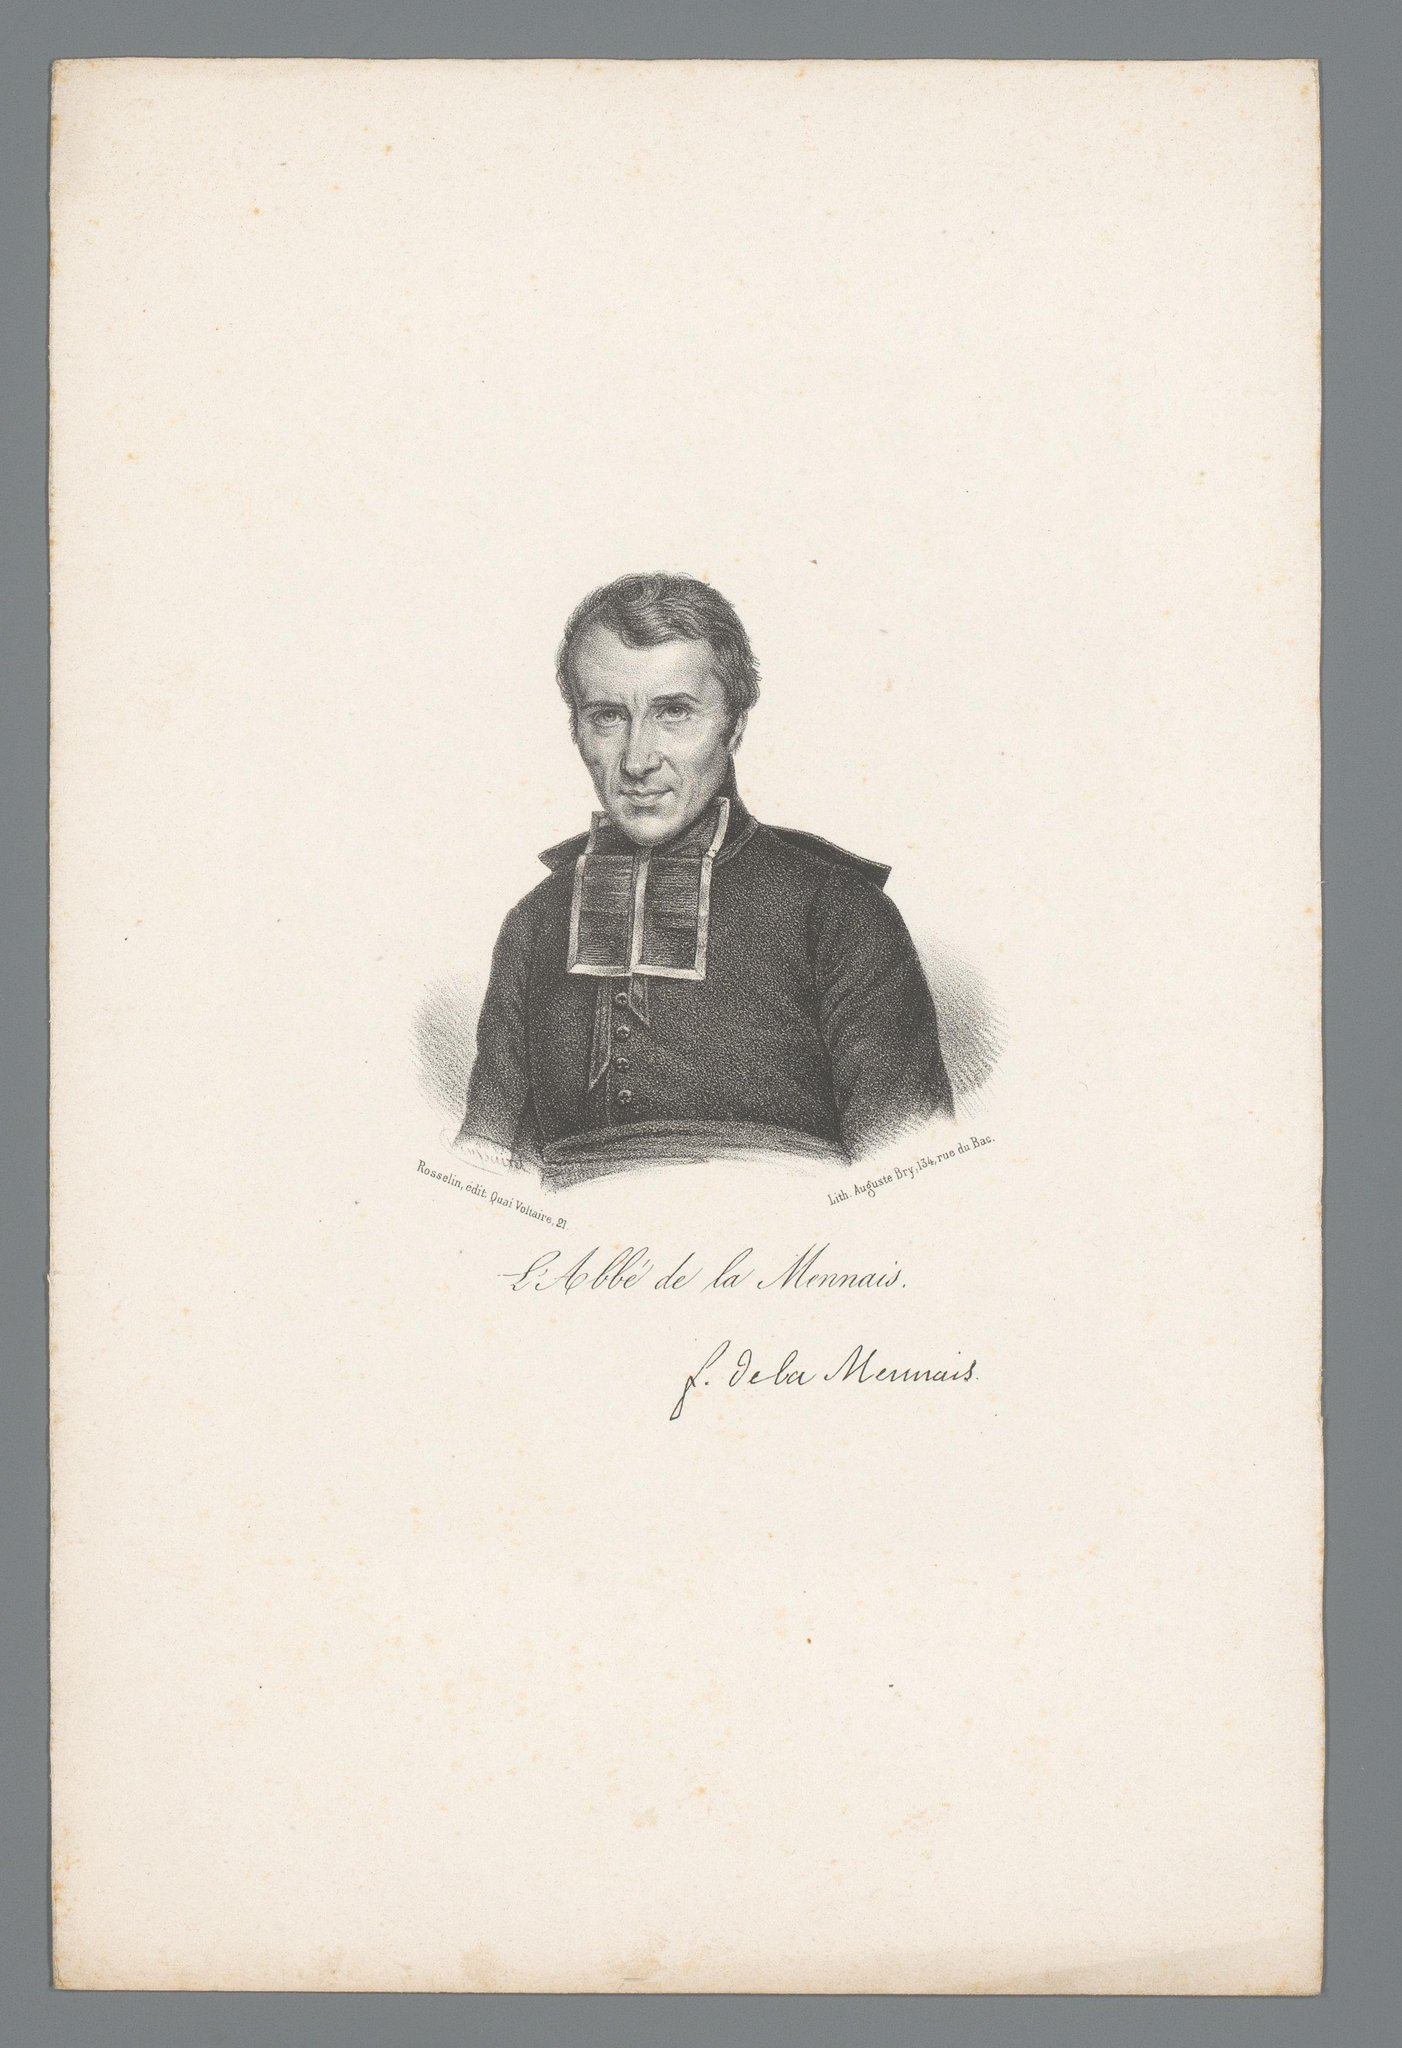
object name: print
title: L'abbé de la Mennais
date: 1846-1848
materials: paper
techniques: lithograph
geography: paris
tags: paris, priest, historical persons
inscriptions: collector's mark: Lugt 2228